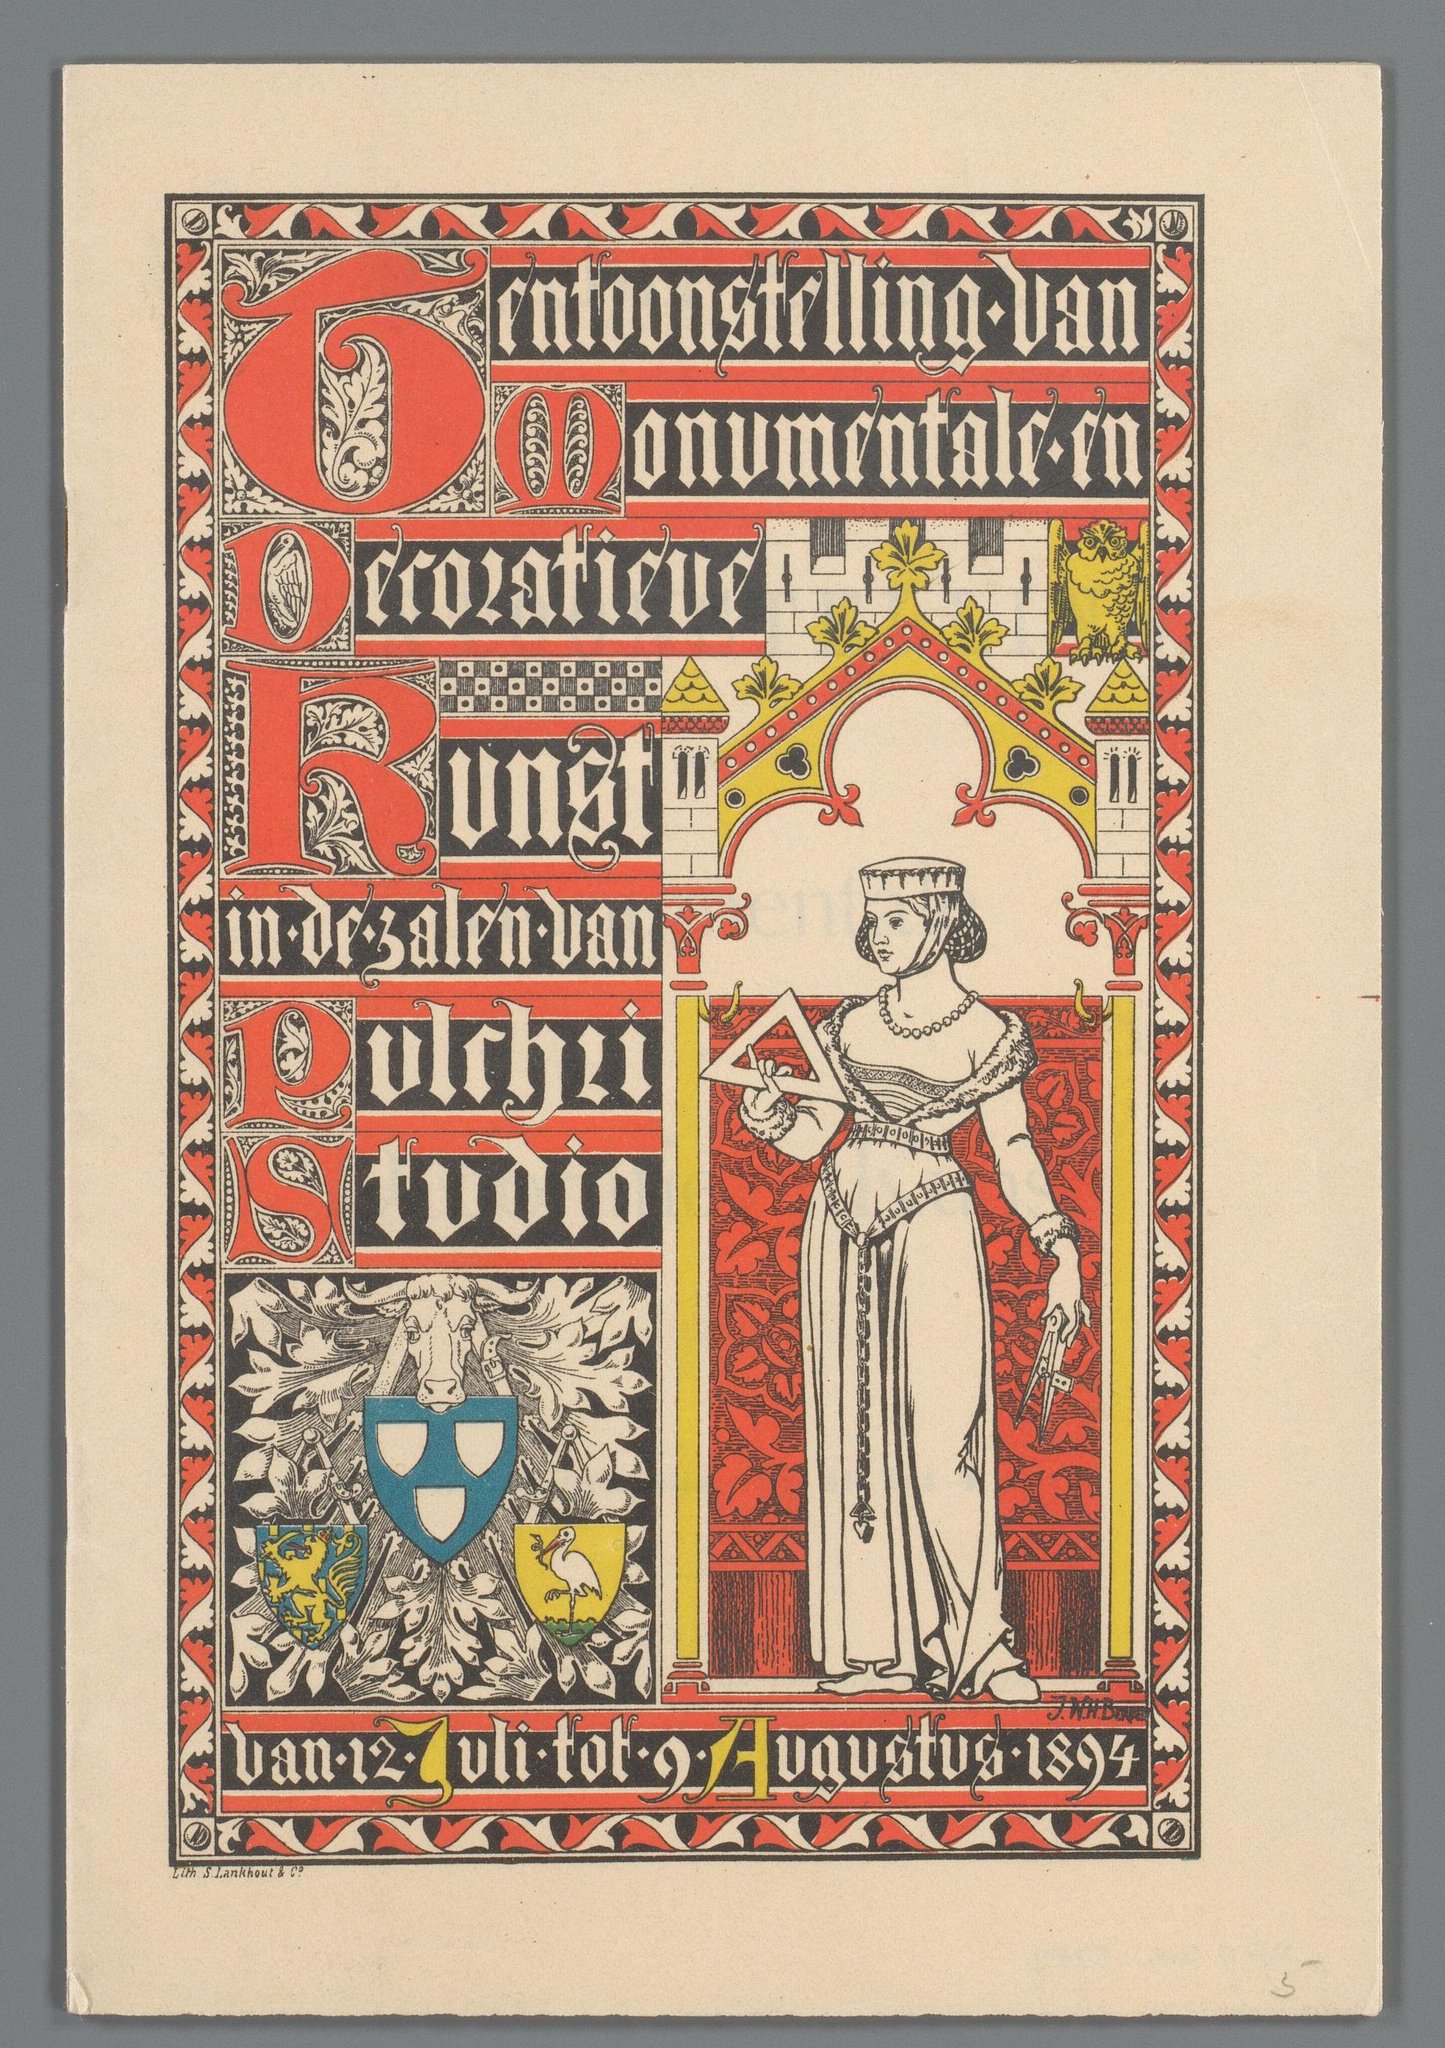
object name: photomechanical print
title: Catalogus bij de tentoonstelling van monumentale en decoratieve kunst van Pulchri Studio, 1894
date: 1894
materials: paper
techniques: letterpress printing, printing block, stapling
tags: drawing-instruments, initial, compasses, collection, exhibition, show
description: Op de voorzijde van de publicatie een decoratief kader met belettering in middeleeuwse stijl: 'Tentoonstelling van monumentale en decoratieve kunst in de zalen van Pulchri Studio van 12 juli tot 9 augustus 1894'. Verder op de afbeelding een vrouw in middeleeuwse kledij, met een passer en driehoek. De volgende veertien pagina's geven een opsomming van de tentoongestelde werken.